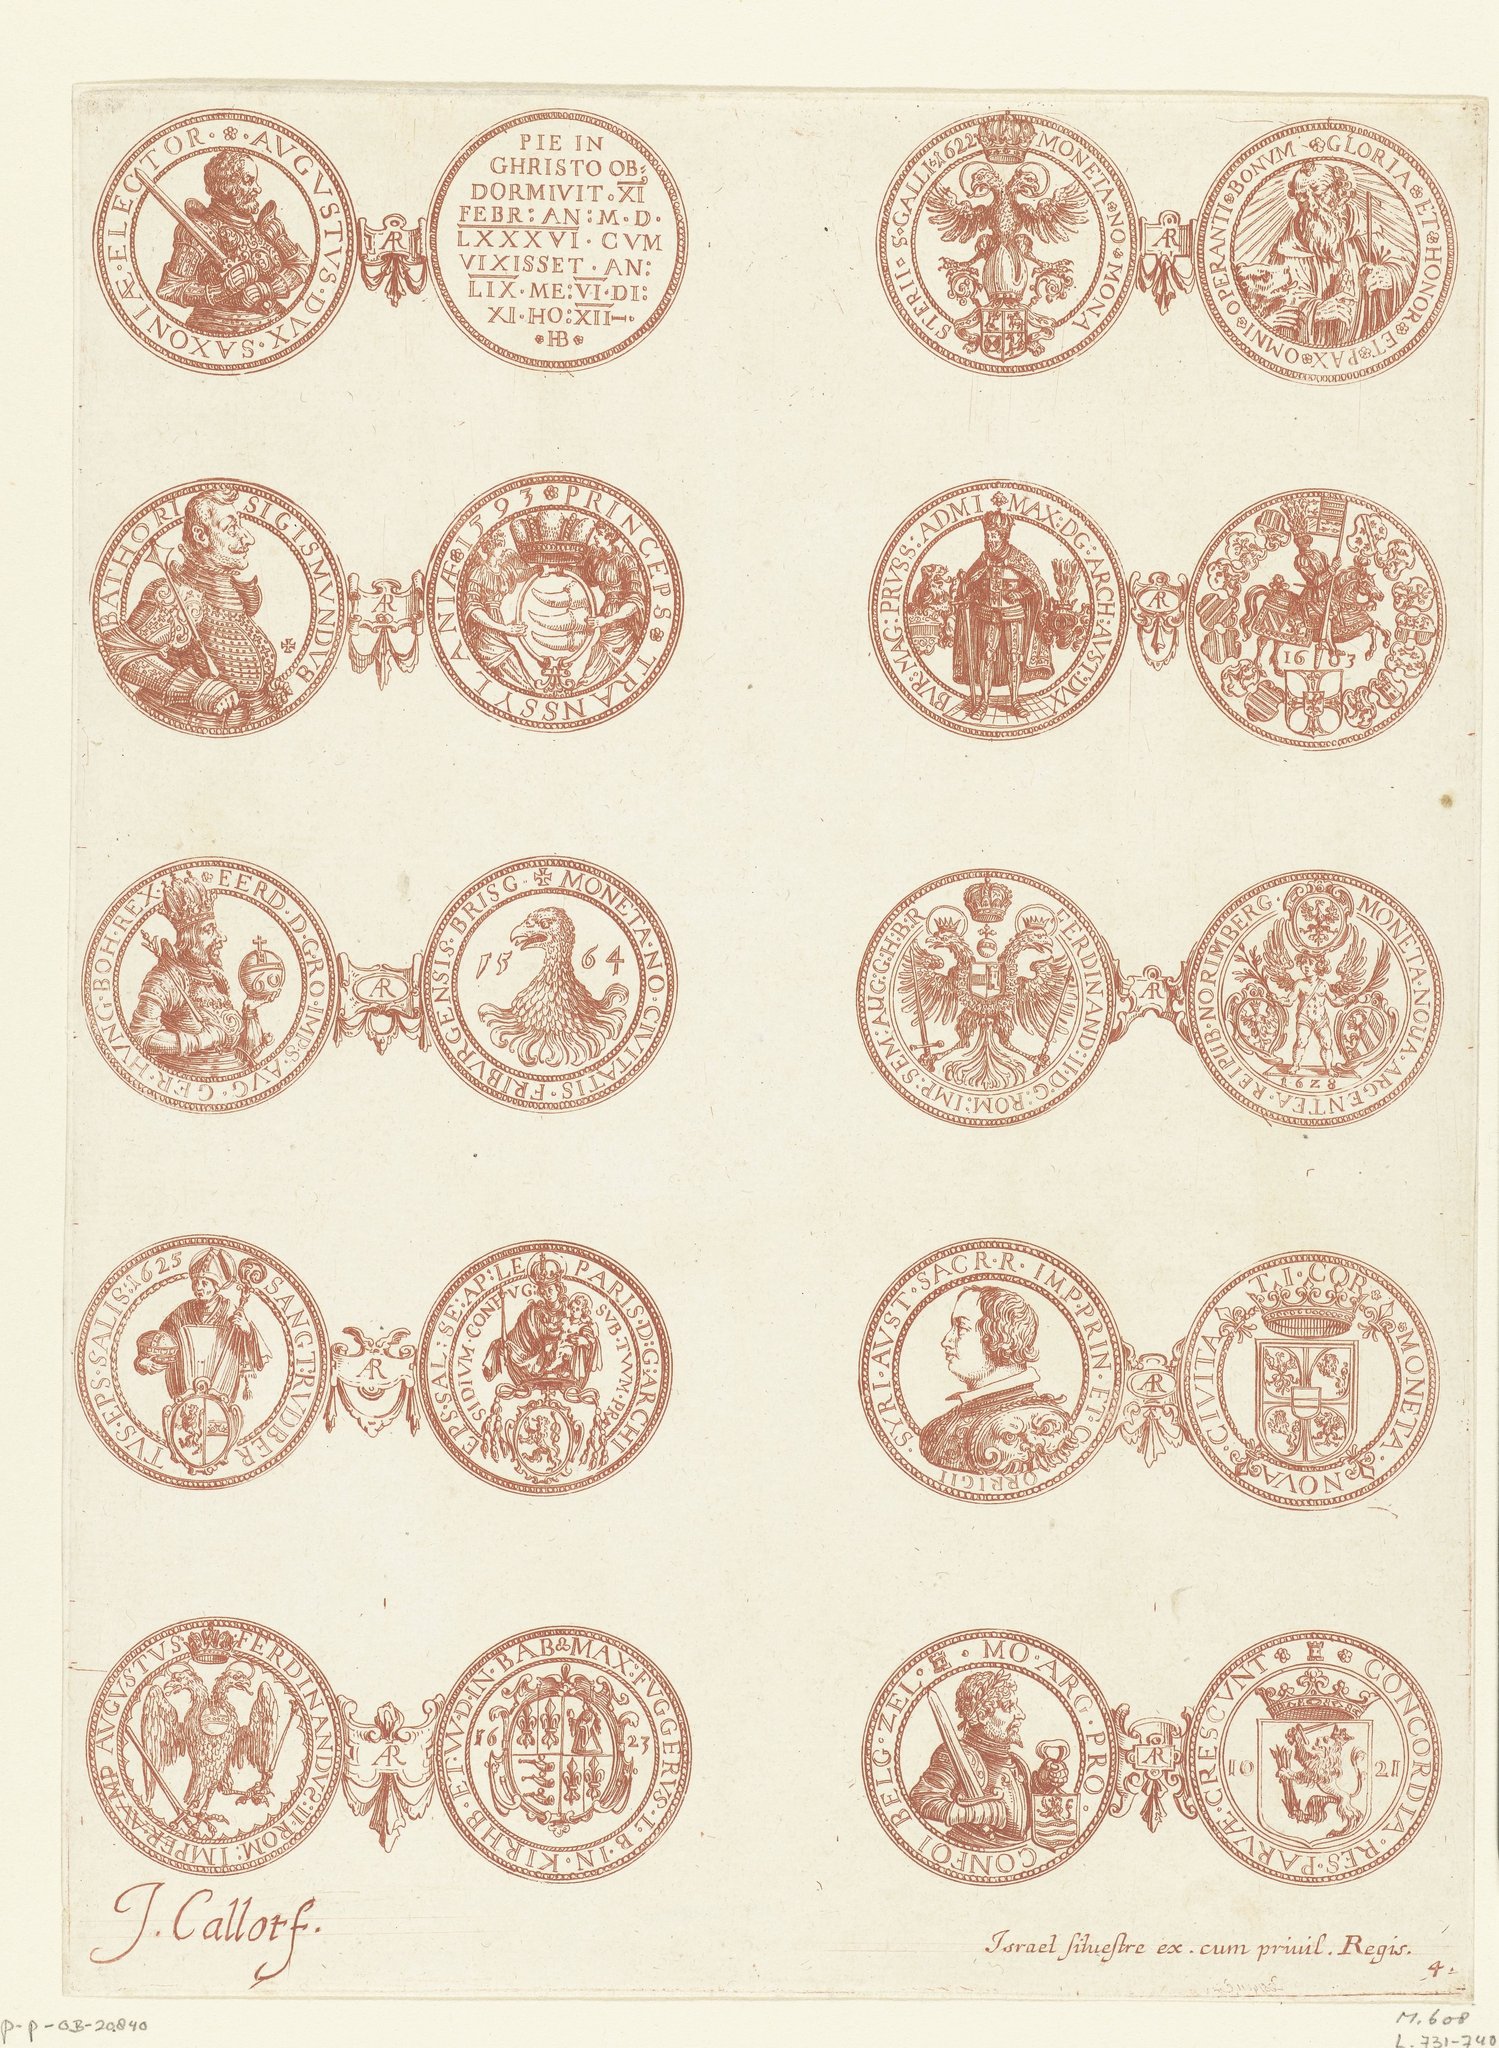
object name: print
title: Tien Europese munten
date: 1629-1630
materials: paper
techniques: etching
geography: nancy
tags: coin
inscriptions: collector's mark: Lugt 240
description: Tien Europese munten, in twee kolommen van vijf afgebeeld. Deze prent is onderdeel van een serie van tien prenten met voorstellingen van munten die tussen 1522 en 1629 in omloop gebracht zijn in Europa, voornamelijk in Duitsland en Italië. Van elke munt zijn de voor- en achterzijde naast elkaar weergegeven, verbonden door een cartouche met de letters AR (argentum - zilver) of AV (aureum - goud). De zilveren munten beslaan de eerste negen bladen en een deel van het tiende blad, dat verder voornamelijk gouden munten toont.